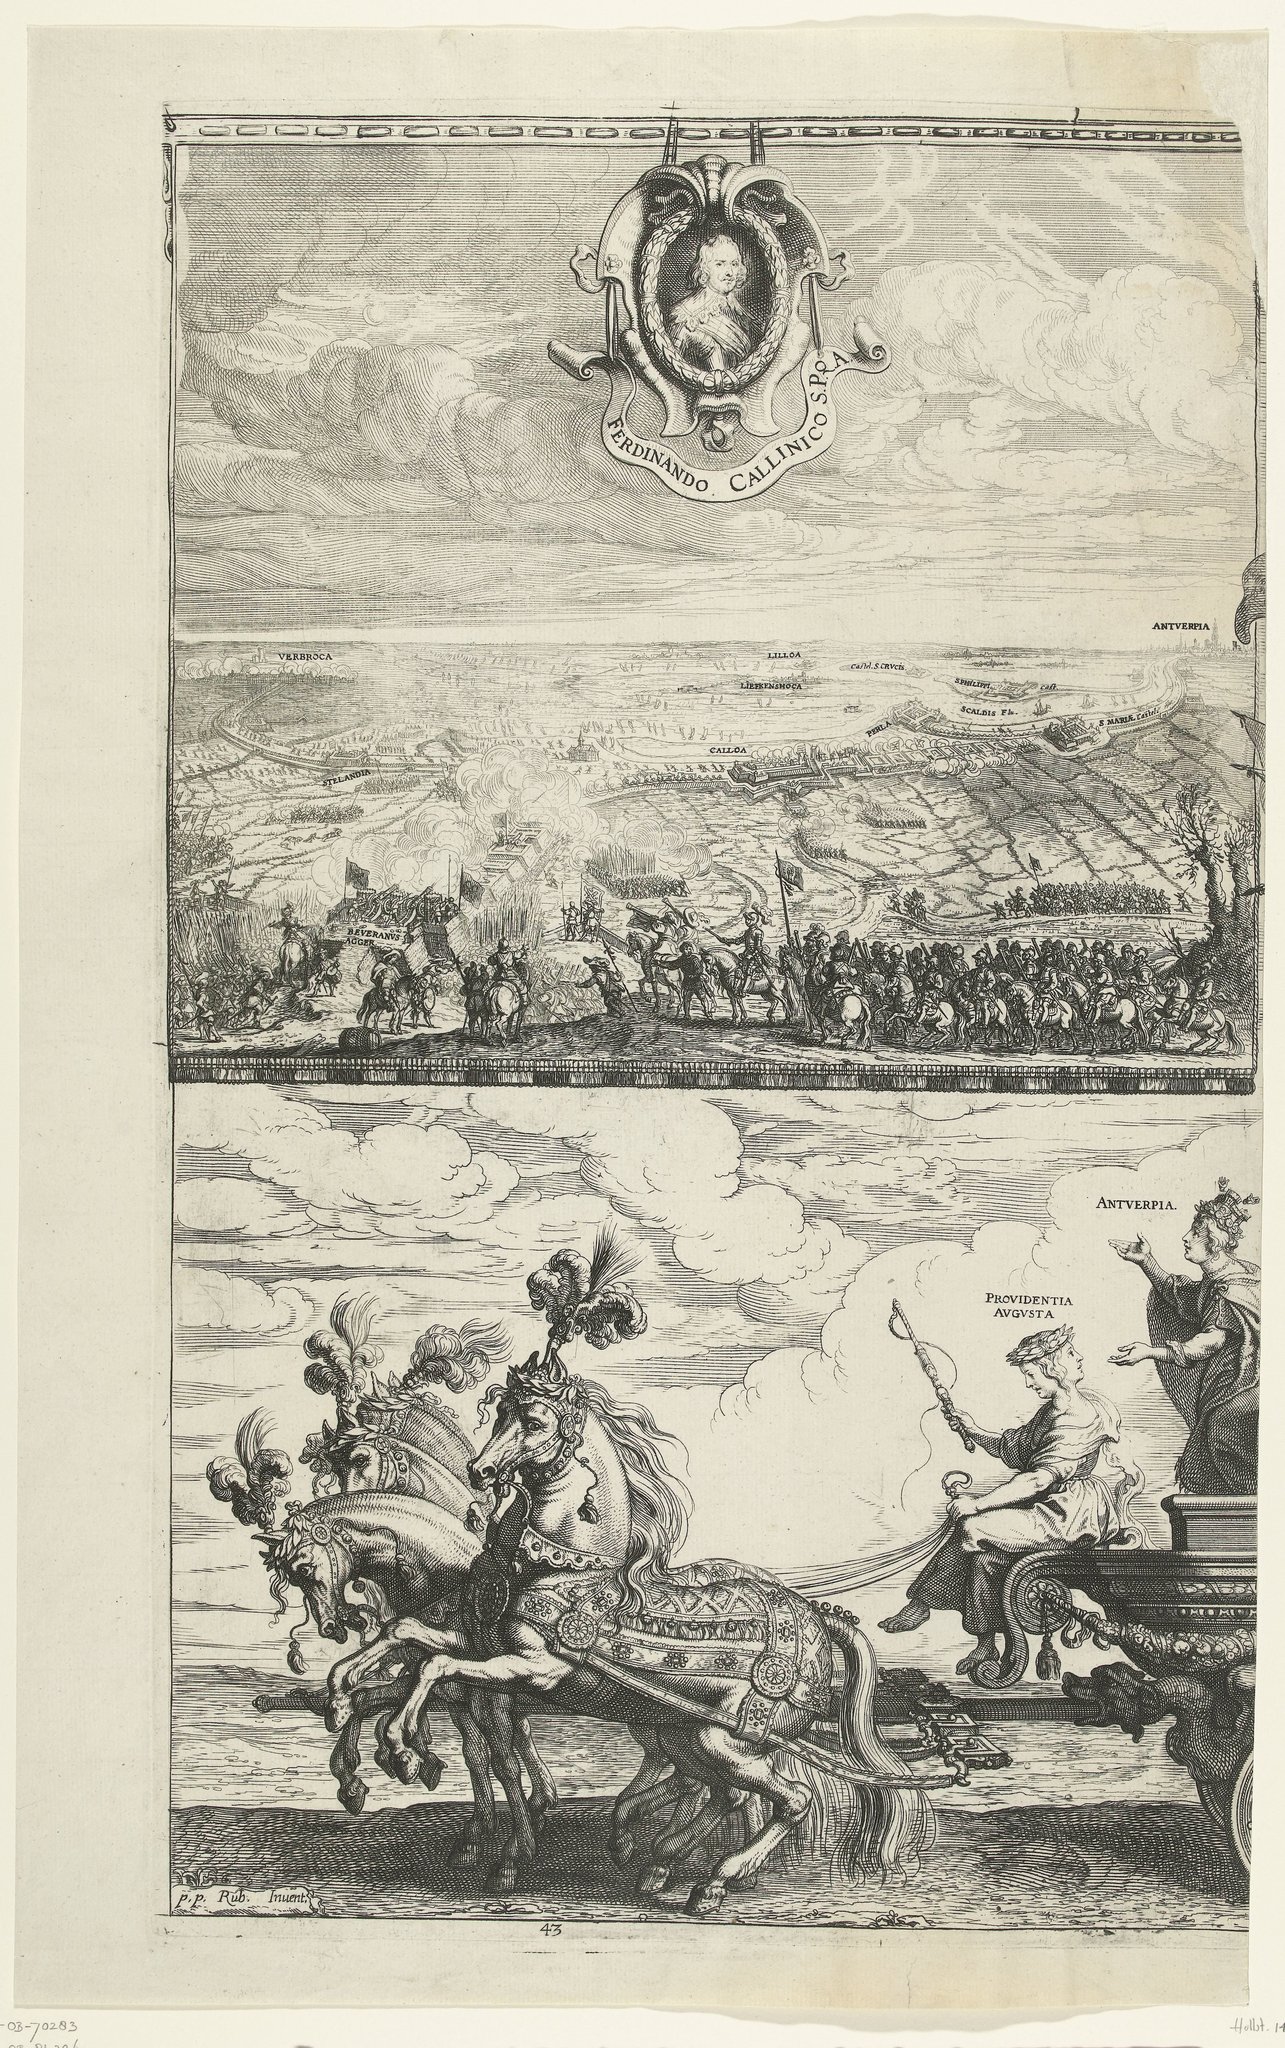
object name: print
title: Laurea Calloana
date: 1639-1641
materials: paper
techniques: engraving, etching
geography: southern netherlands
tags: brussels, landvoogd der zuidelijke nederlanden ferdinand van oostenrijk, float ~ triumph, battle (+ land forces), roman chariot, quadriga ~ triumph, antwerp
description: De triomfwagen van Kallo gebouwd ter viering van de overwinning van het Spaanse leger op het Staatse leger bij Fort Kallo op 21 juni 1638 en gebruikt in de jaarlijkse Ommegang. Met het vierspan paarden en de eerste allegorische figuren op de kar. Linksboven een hangend kleed met een voorstelling van de veldslag en een portret van Ferdinand. Linkerhelft van een voorstelling op twee bladen. Blad nr. 43 in een geheel van 43 platen die de uitgave van de beschrijving van de intocht van de Kardinaal Infant Ferdinand van Oostenrijk te Antwerpen op 17 april 1635 als de nieuwe landvoogd voor de Spaanse Nederlanden illustreren.